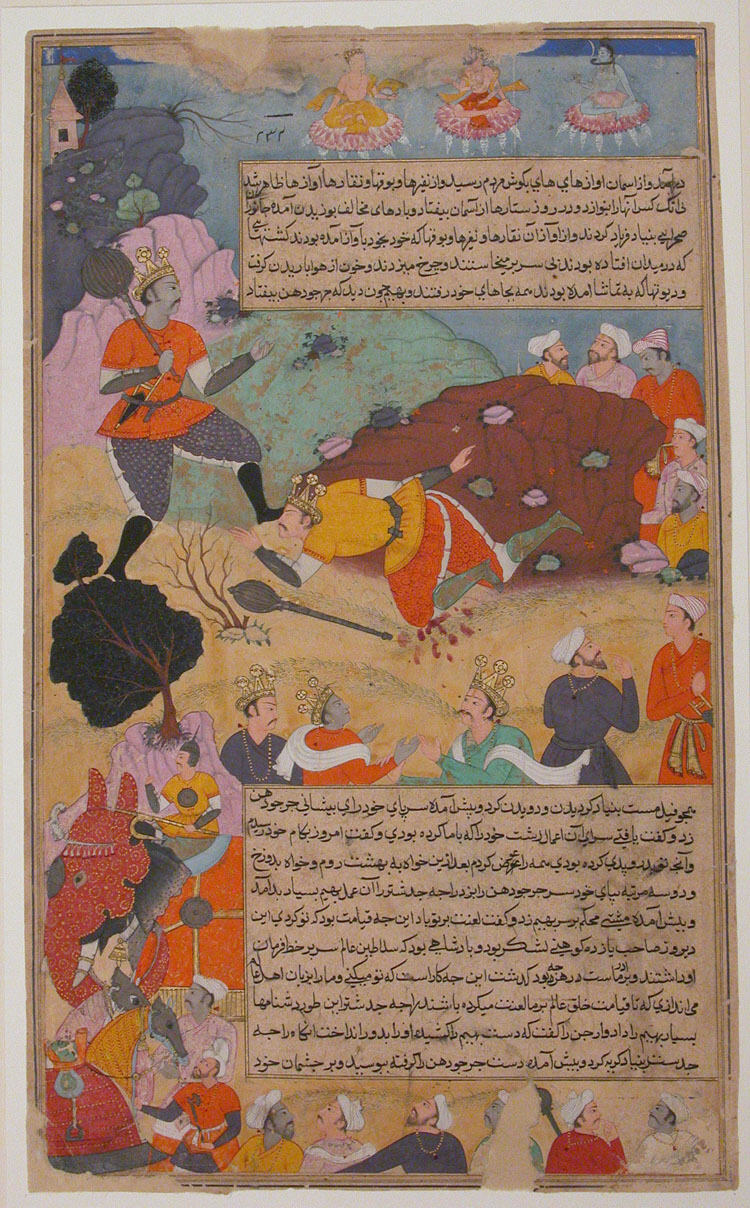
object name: folio from an illustrated manuscript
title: "Bhima Defeates Duryodhana", Folio from a Razmnama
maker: 'abd al-rahim ibn muhammad bairam khan khan-i khanan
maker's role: patron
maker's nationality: indian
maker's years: 1556-1627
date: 1616-1617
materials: gold, ink, paper, watercolor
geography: india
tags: battles,men,hinduism